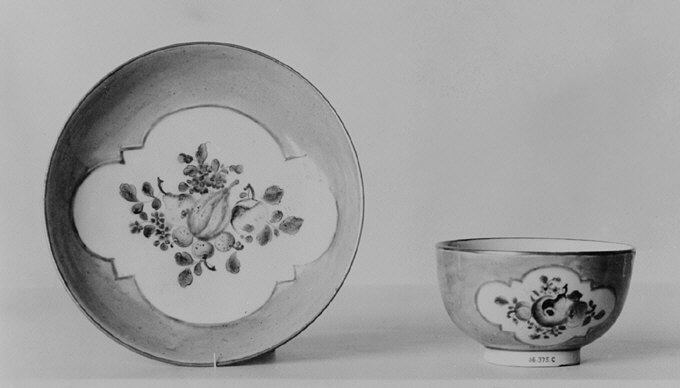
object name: cup and saucer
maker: le nove porcelain manufactory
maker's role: manufactory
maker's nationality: italian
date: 1760-1765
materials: soft paste porcelain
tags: flowers